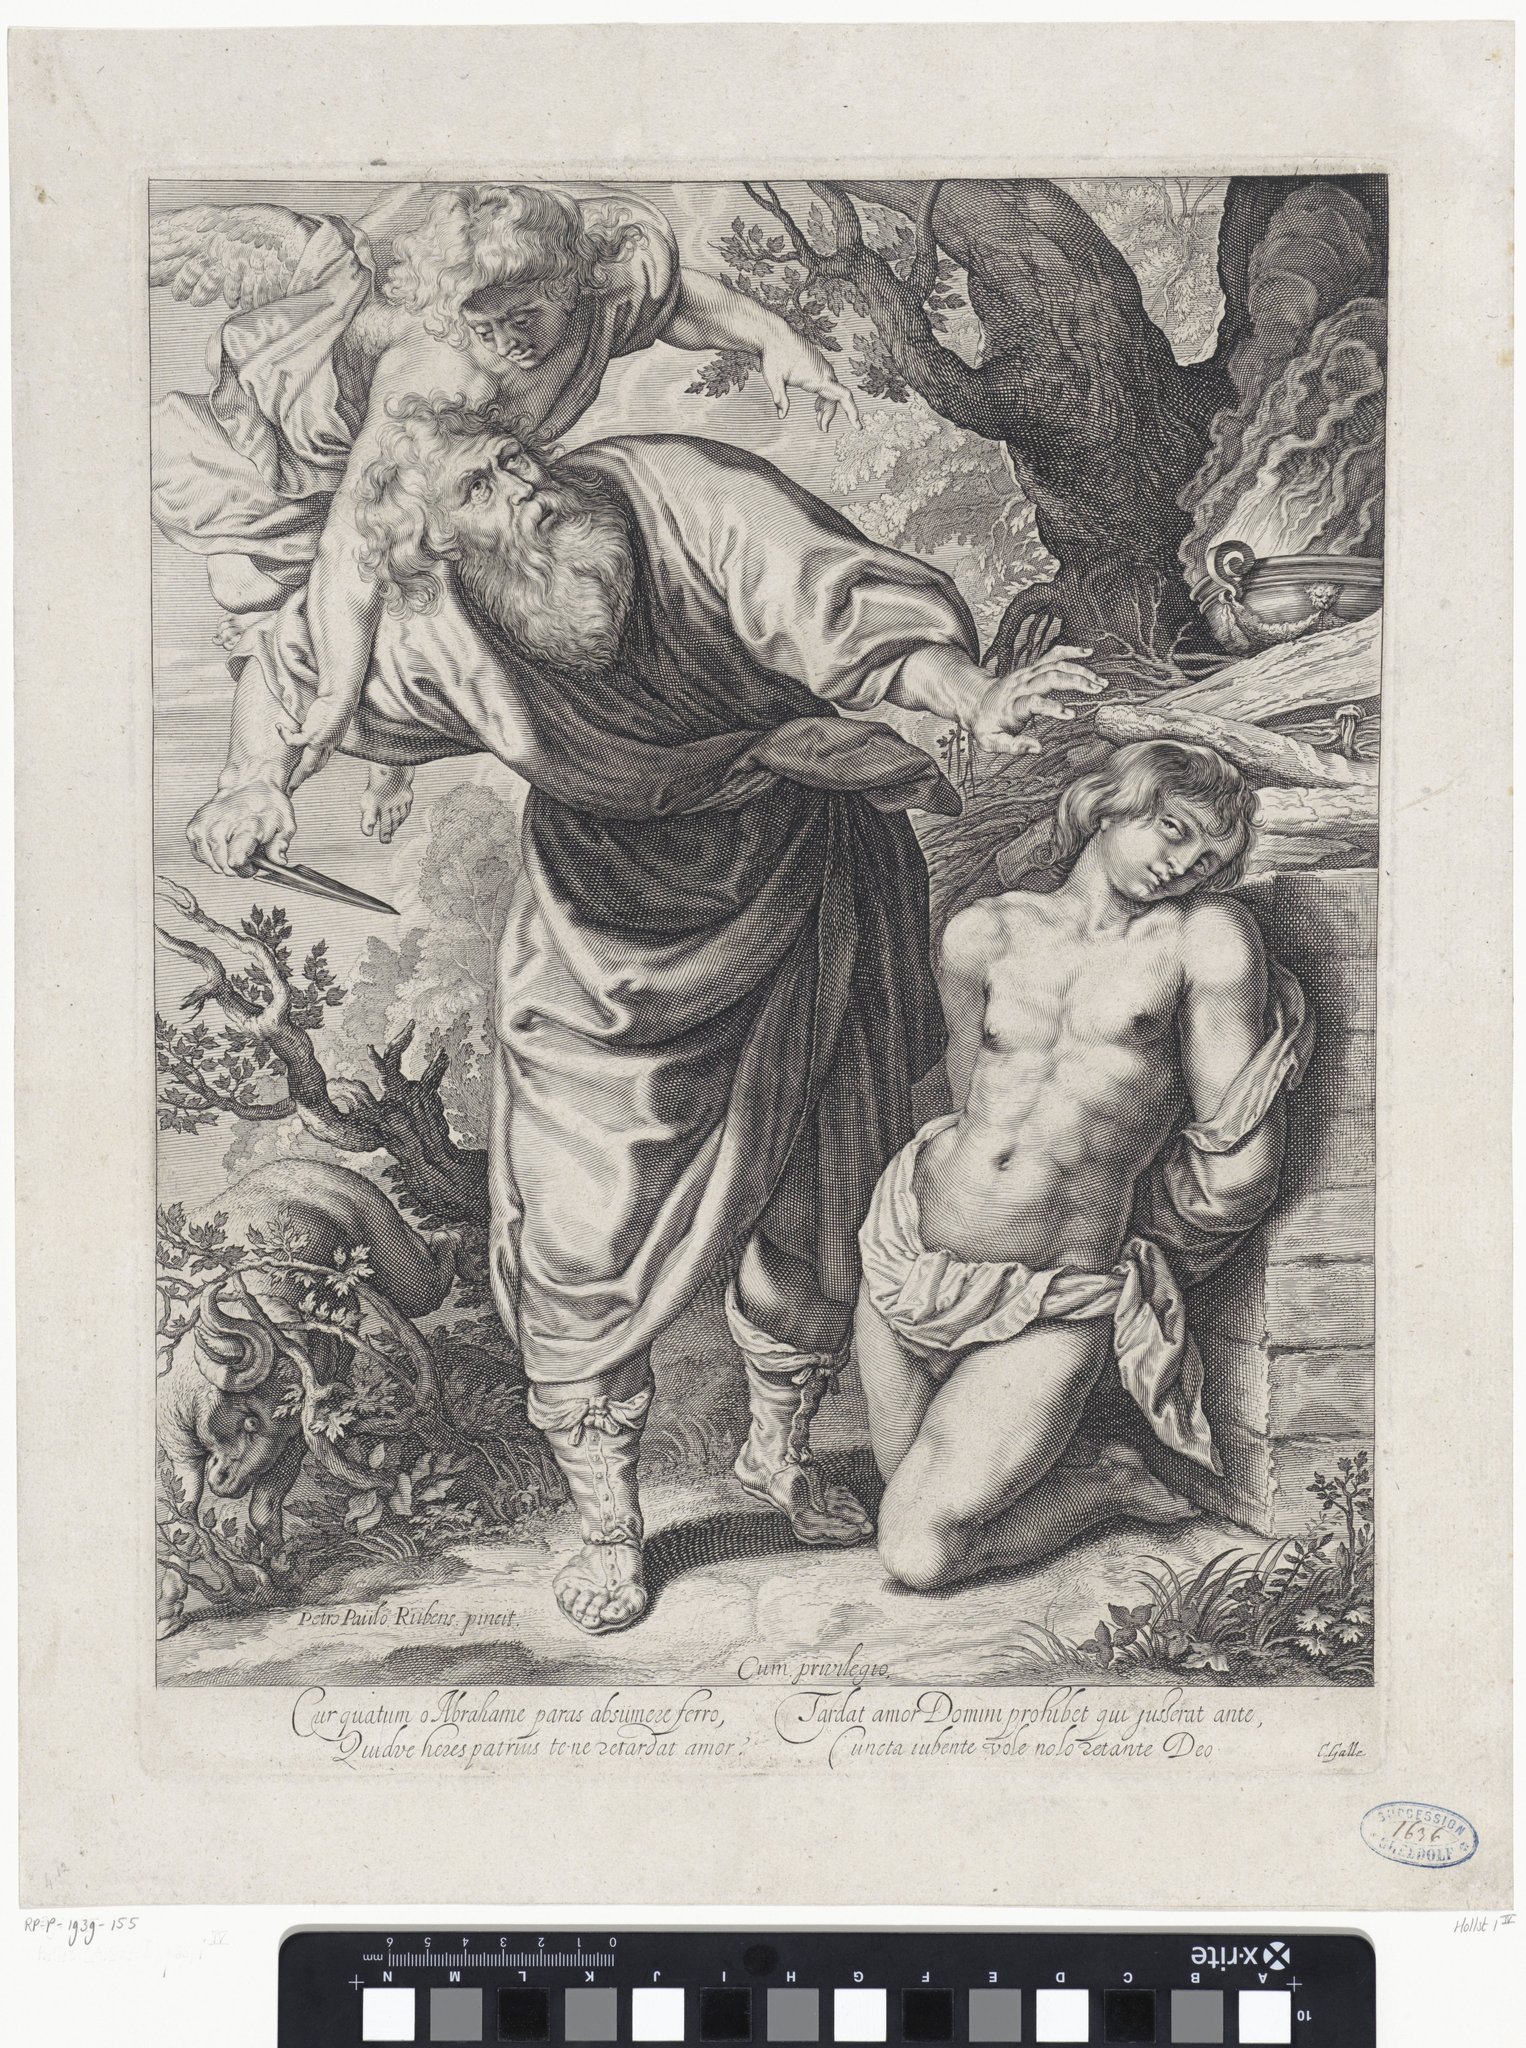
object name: print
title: Offer van Isaak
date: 1638-1698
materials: paper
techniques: engraving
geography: the hague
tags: the sacrifice of isaac (genesis 22)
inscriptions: collector's mark: Lugt 2228, collector's mark: Lugt 1080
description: Abraham, met een mes in de hand, staat op het punt zijn zoon Isaak te offeren, maar een engel weerhoudt hem daarvan. Links een ram in de struiken, die in Isaaks plaats zal worden geofferd.